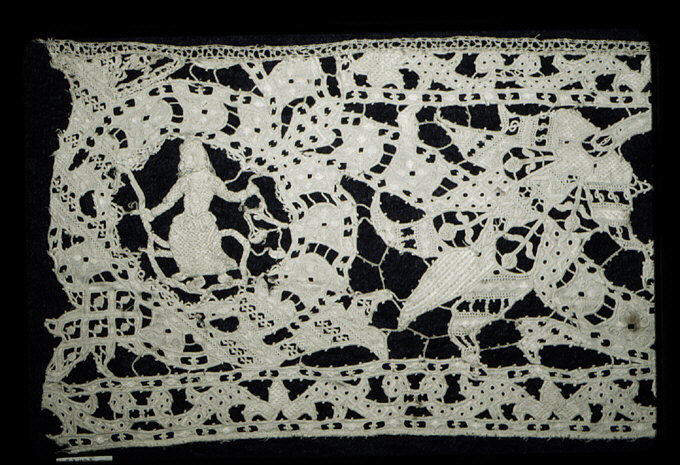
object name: band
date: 1501-1600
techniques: embroidery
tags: human figures